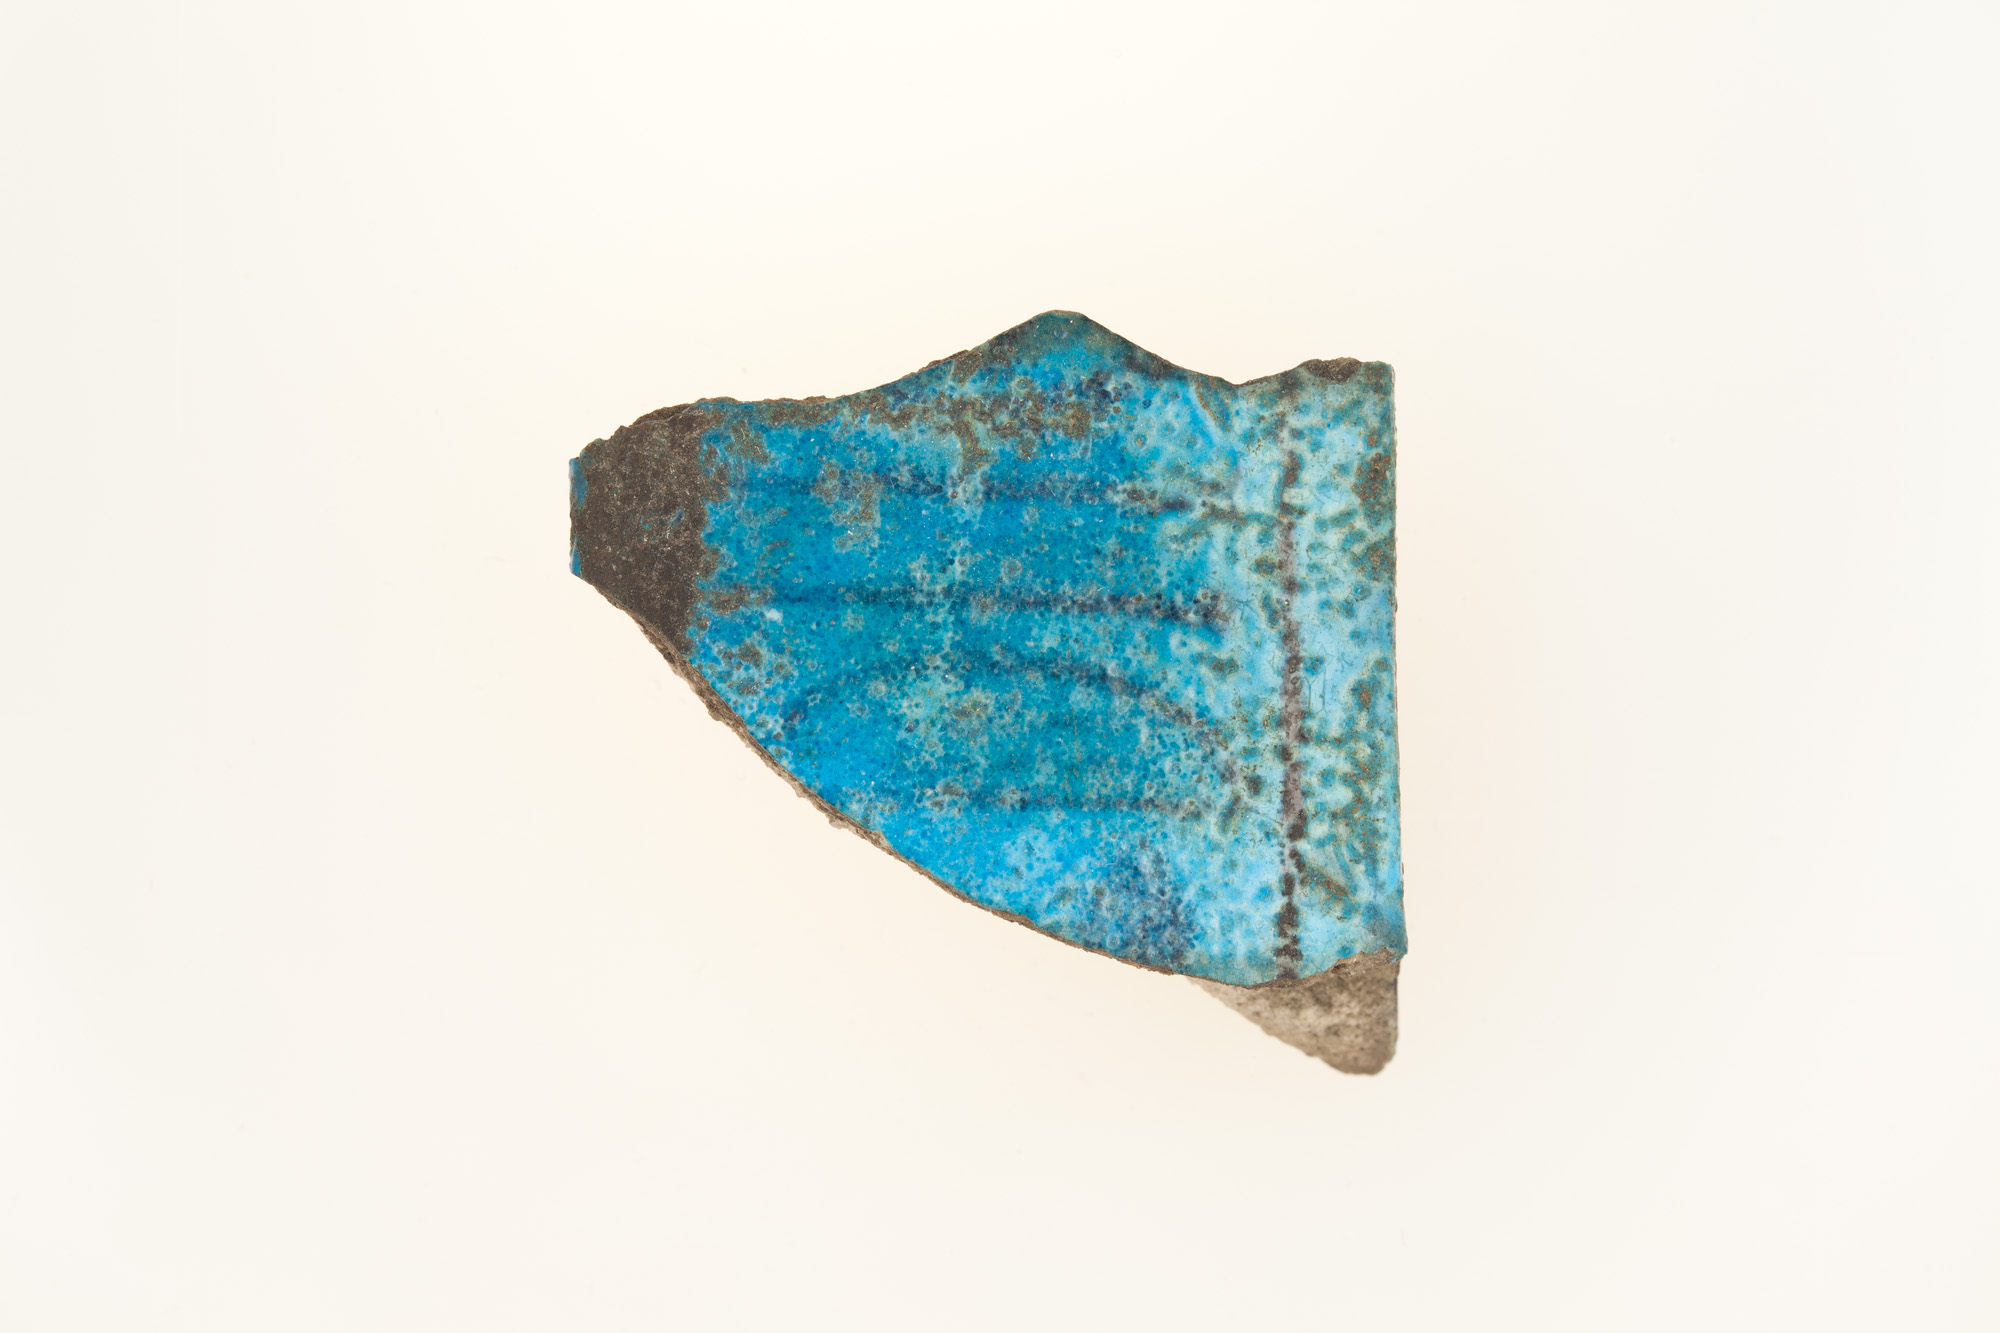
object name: menat fragment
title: Votive Menat fragment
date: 1479-1458 BCE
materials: faience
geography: egypt